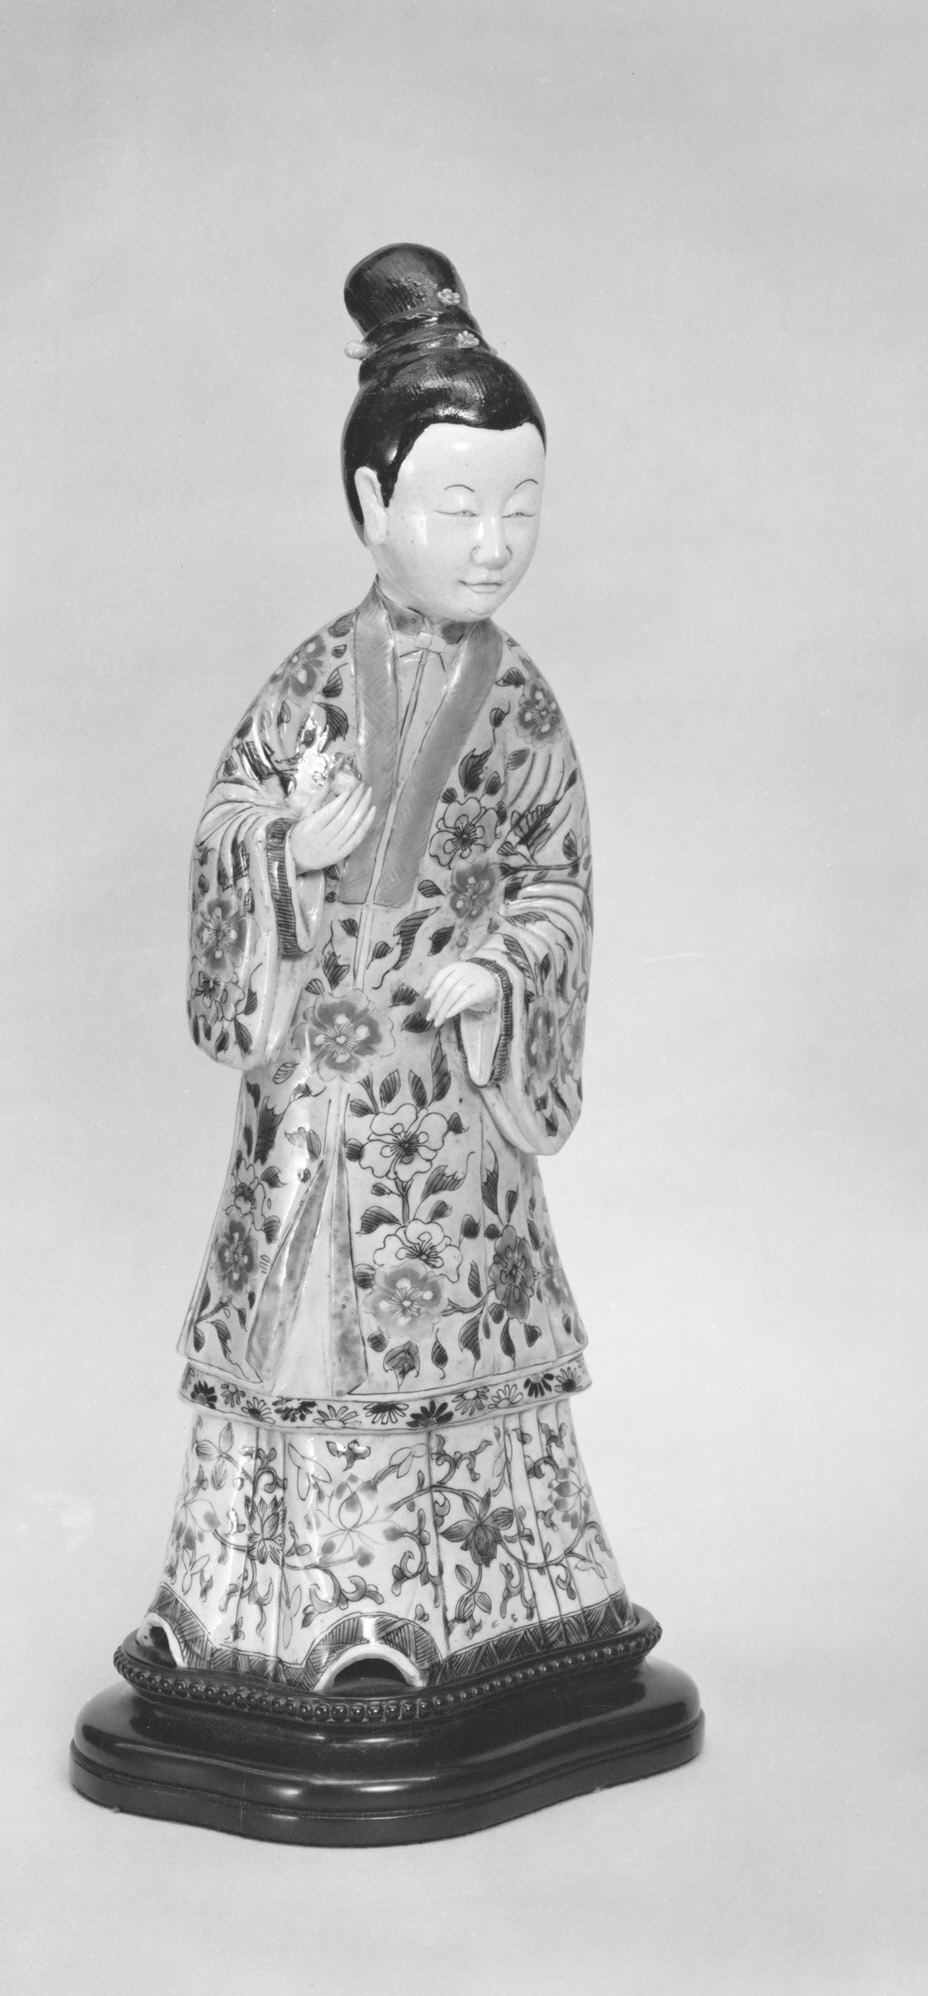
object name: figure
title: Female figure (one of a pair)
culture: chinese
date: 1667-1733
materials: biscuit, enamel, glaze, porcelain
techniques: painting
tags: women